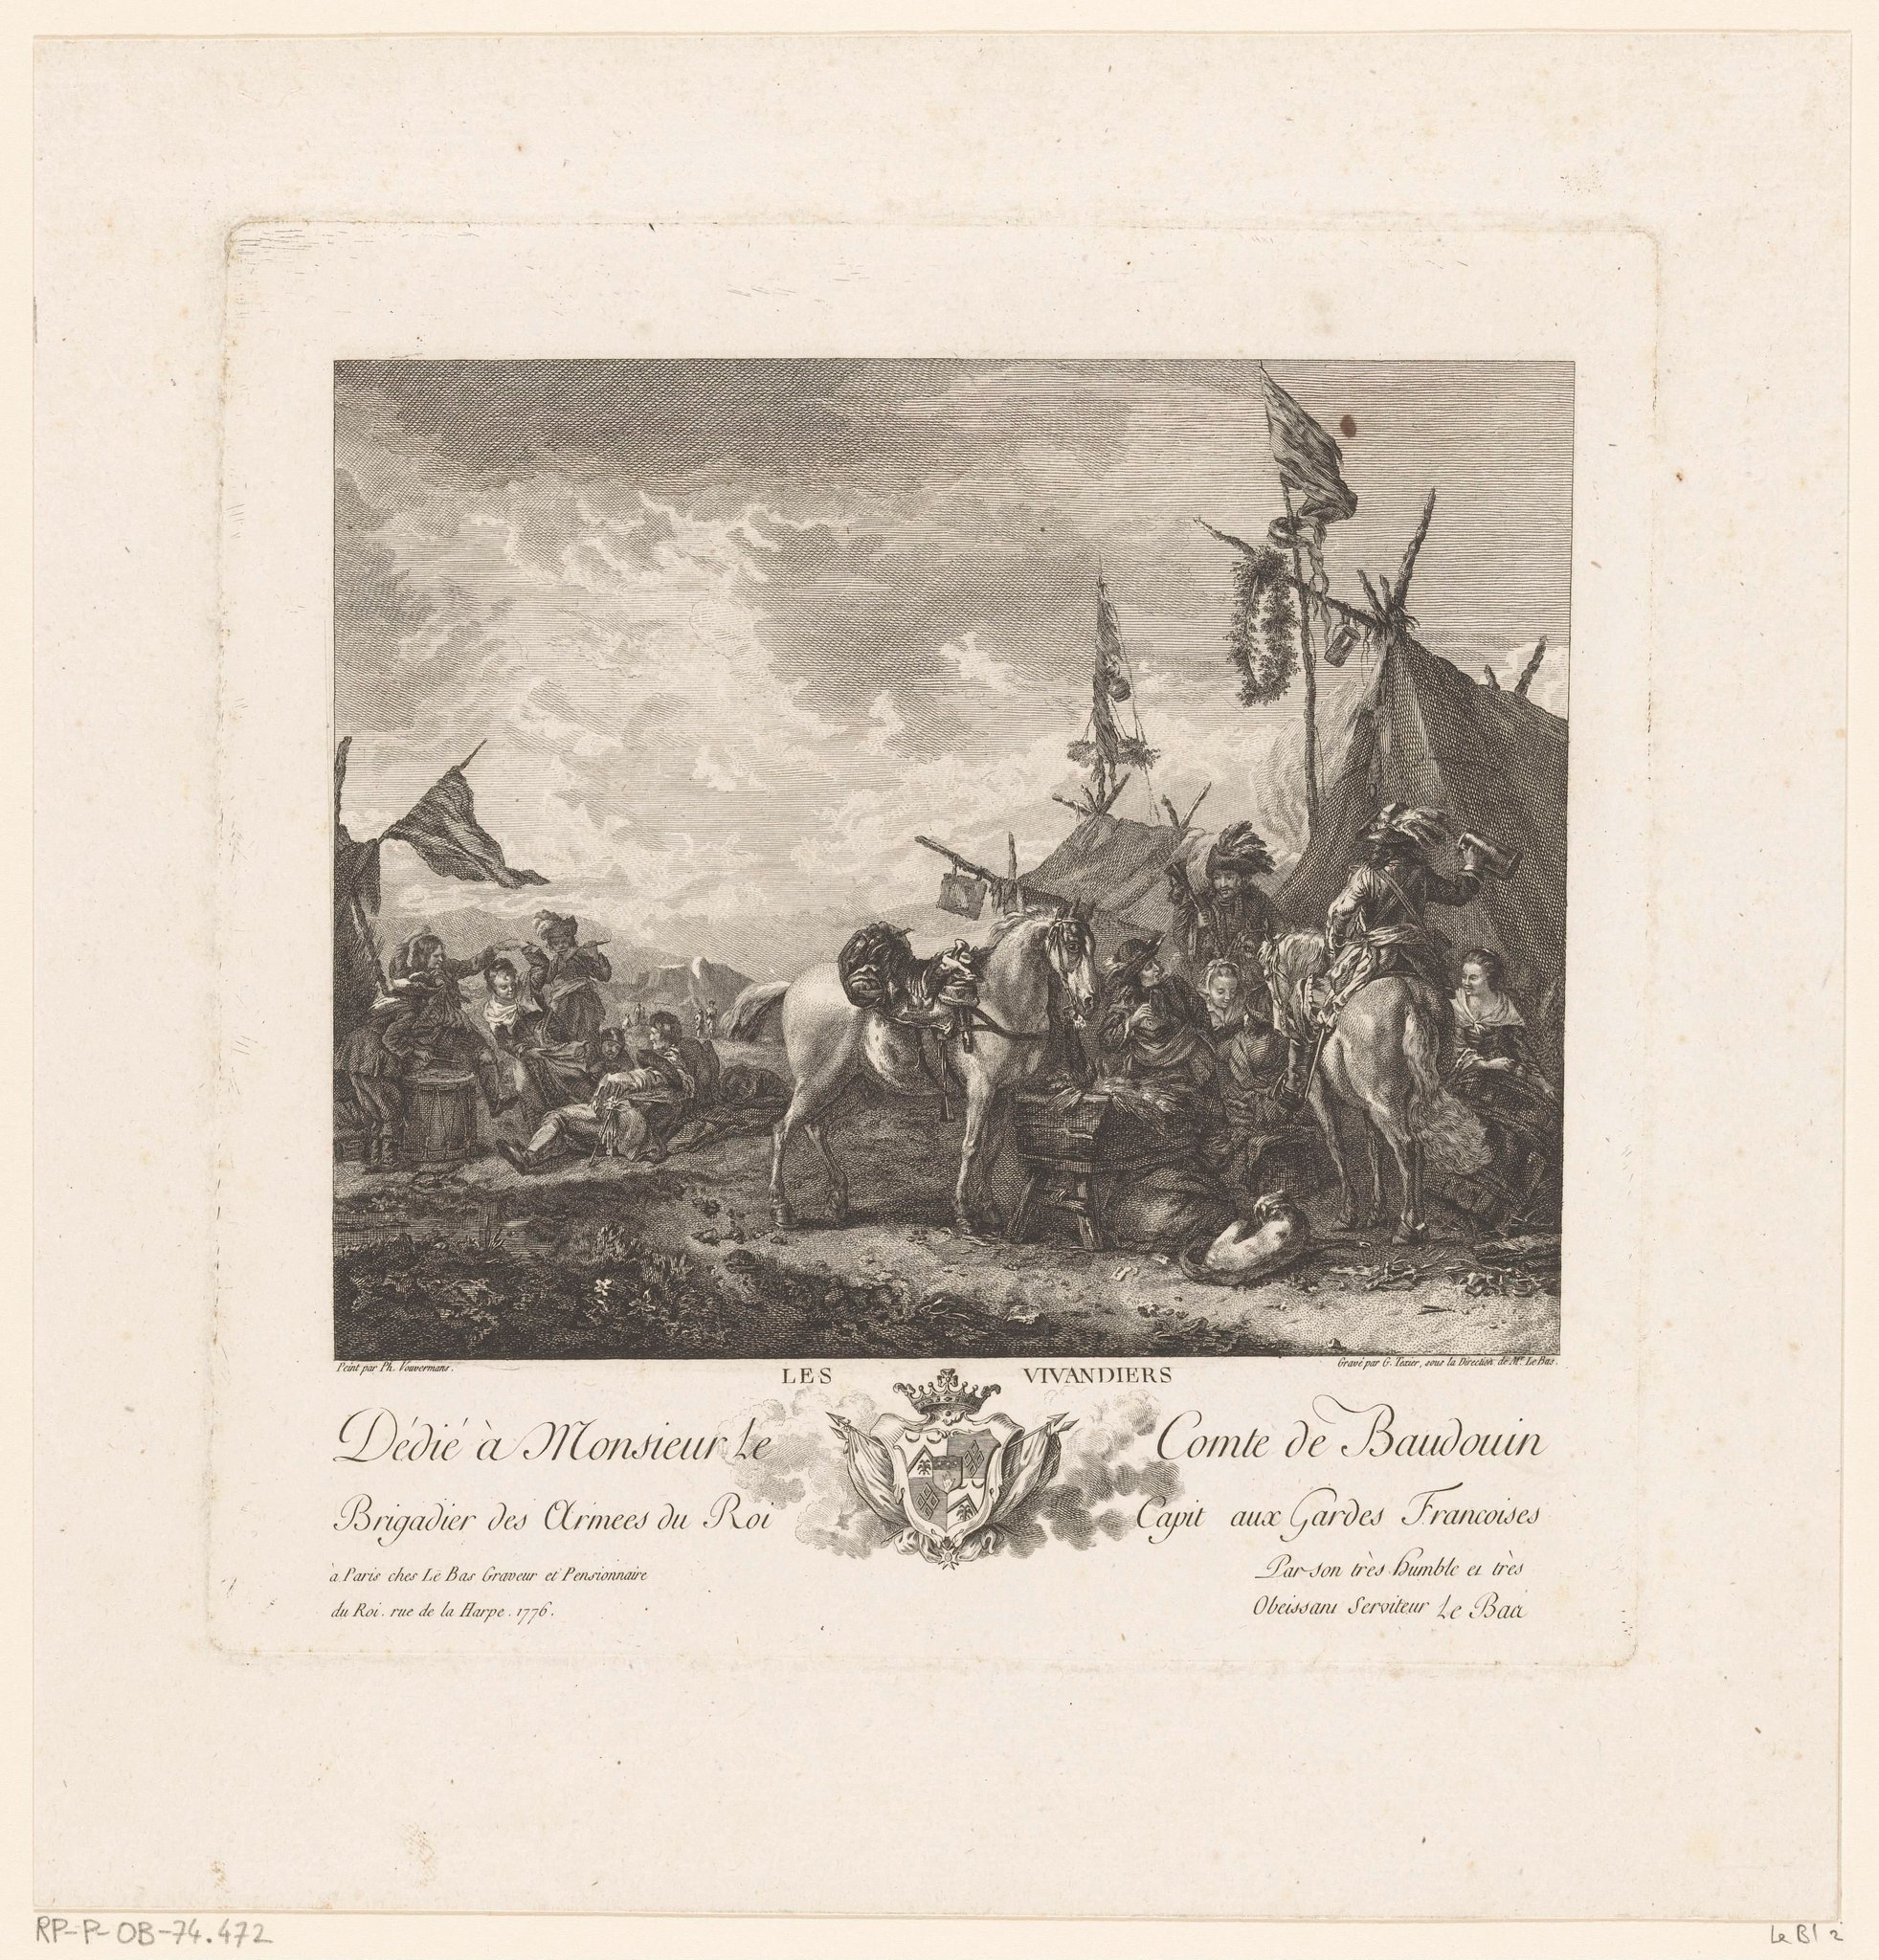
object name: print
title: Les Vivandiers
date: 1776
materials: paper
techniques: engraving, etching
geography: france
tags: army 'en route', the soldier; the soldier's life, female sutler, canteen-woman, male sutler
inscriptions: collector's mark: Lugt 240